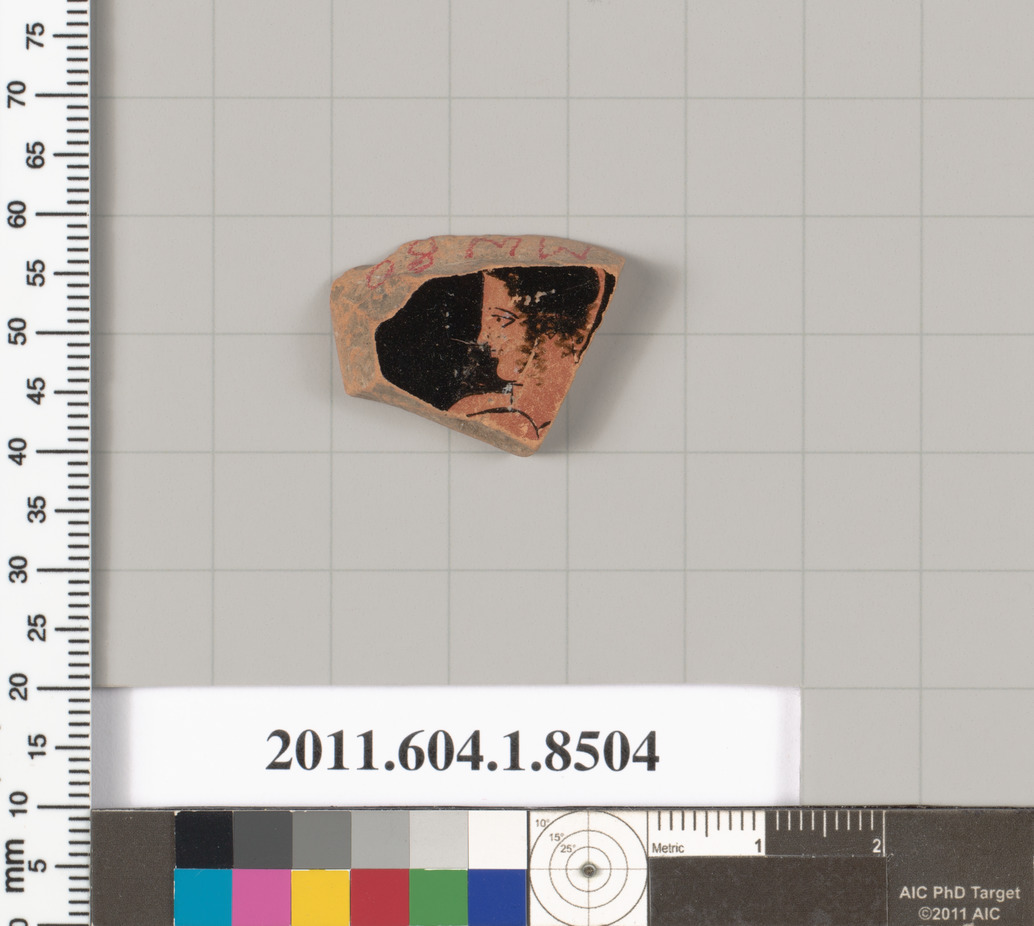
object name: kylix fragment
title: Terracotta fragment of a stemless kylix (drinking cup)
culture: greek, attic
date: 467-435 BCE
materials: terracotta